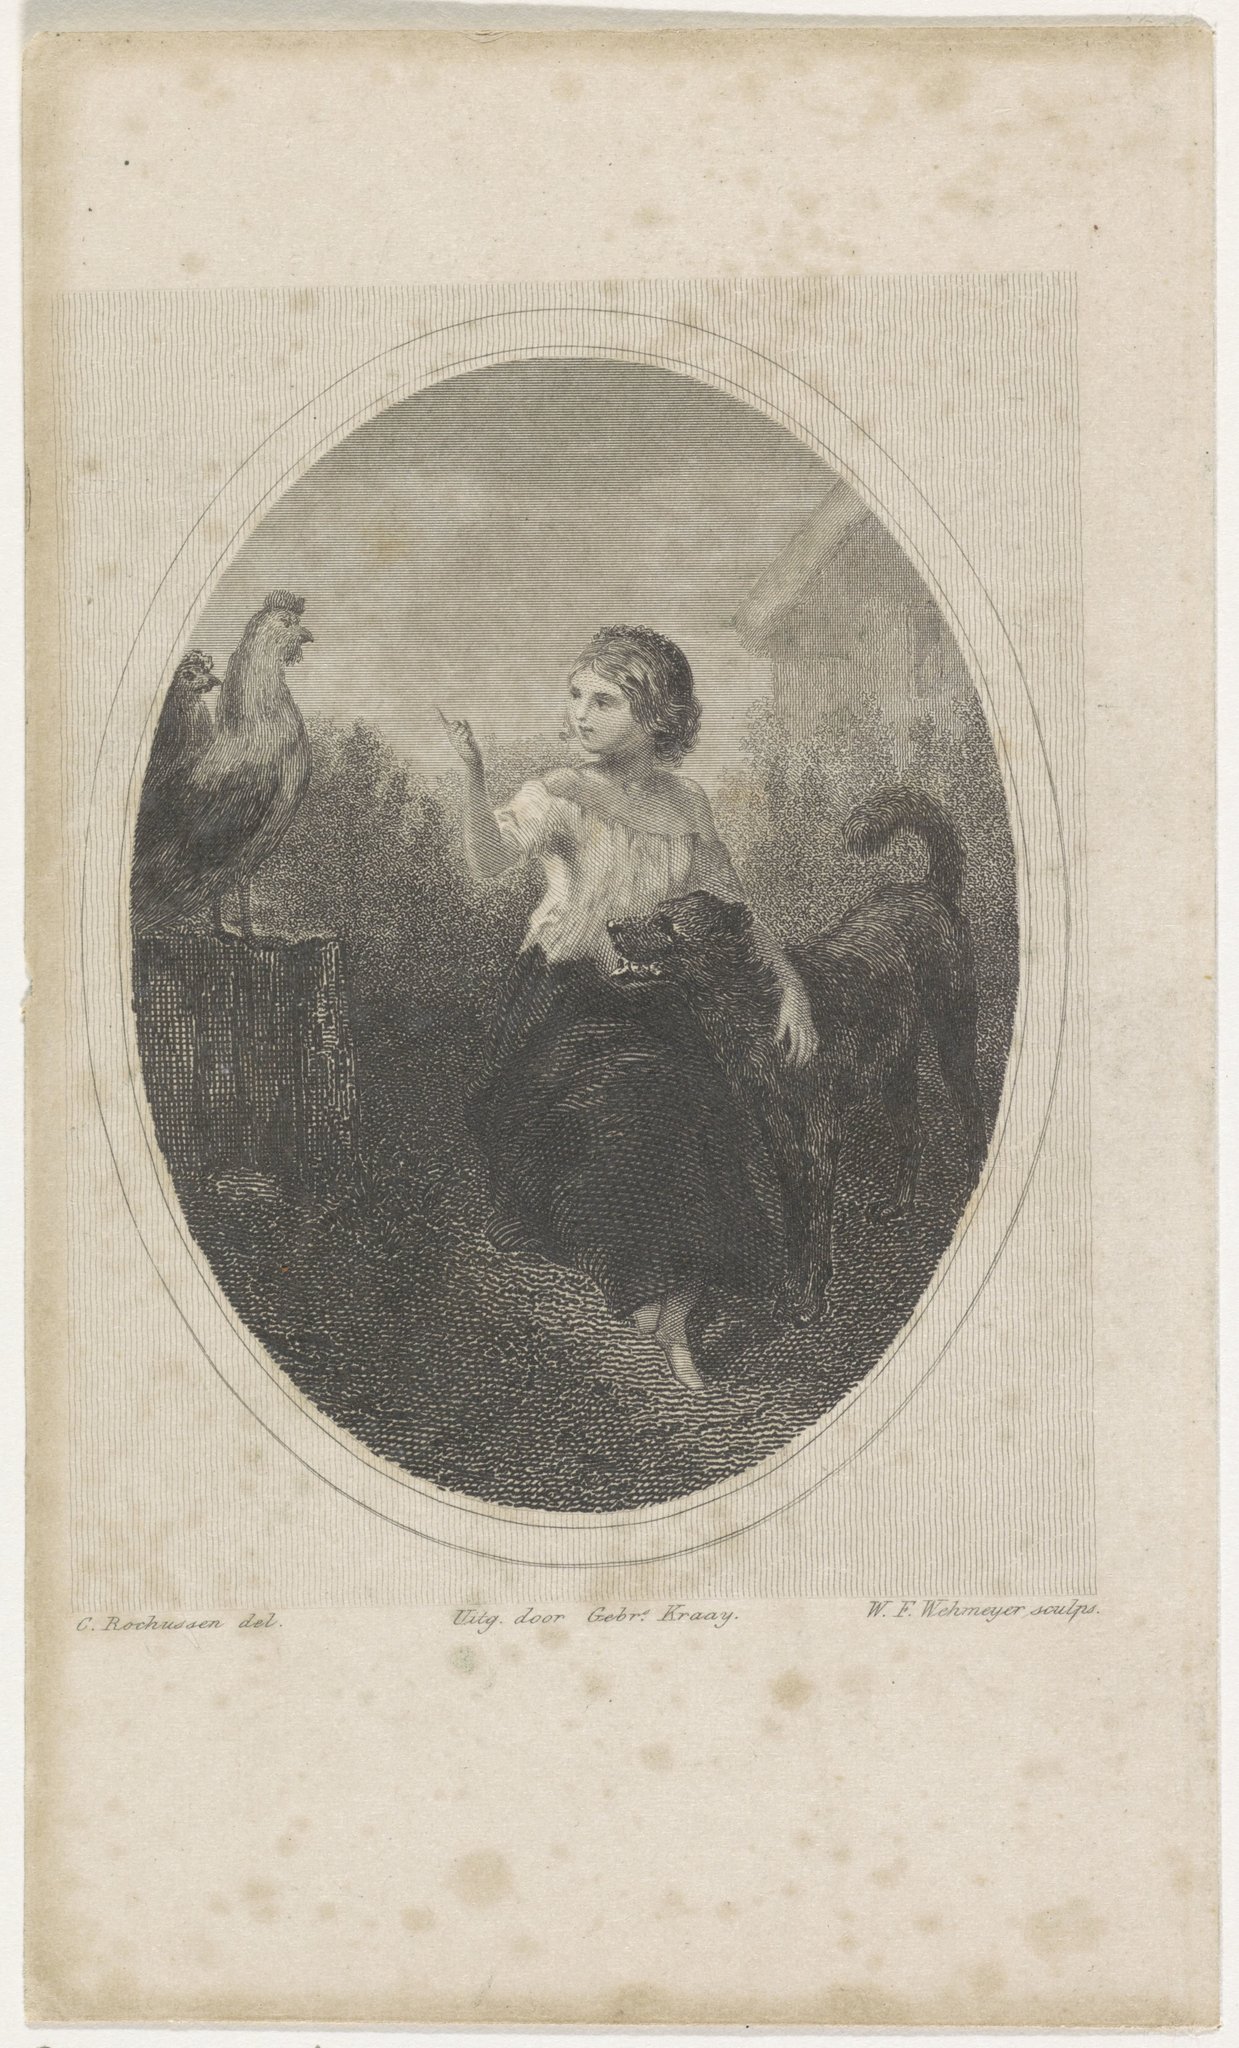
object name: print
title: Meisje met een hond en pluimvee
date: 1834-1854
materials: paper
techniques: engraving, etching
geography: amsterdam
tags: garden, girl (child between toddler and youth), fowl (cock, hen, chicken, etc.), dog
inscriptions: collector's mark: Lugt 2228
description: In een tuin heeft een meisje een arm om een hond heengeslagen. Haar linkerhand steekt ze waarschuwend op in de richting van de kip en de haan die naast haar op een verhoging staan.